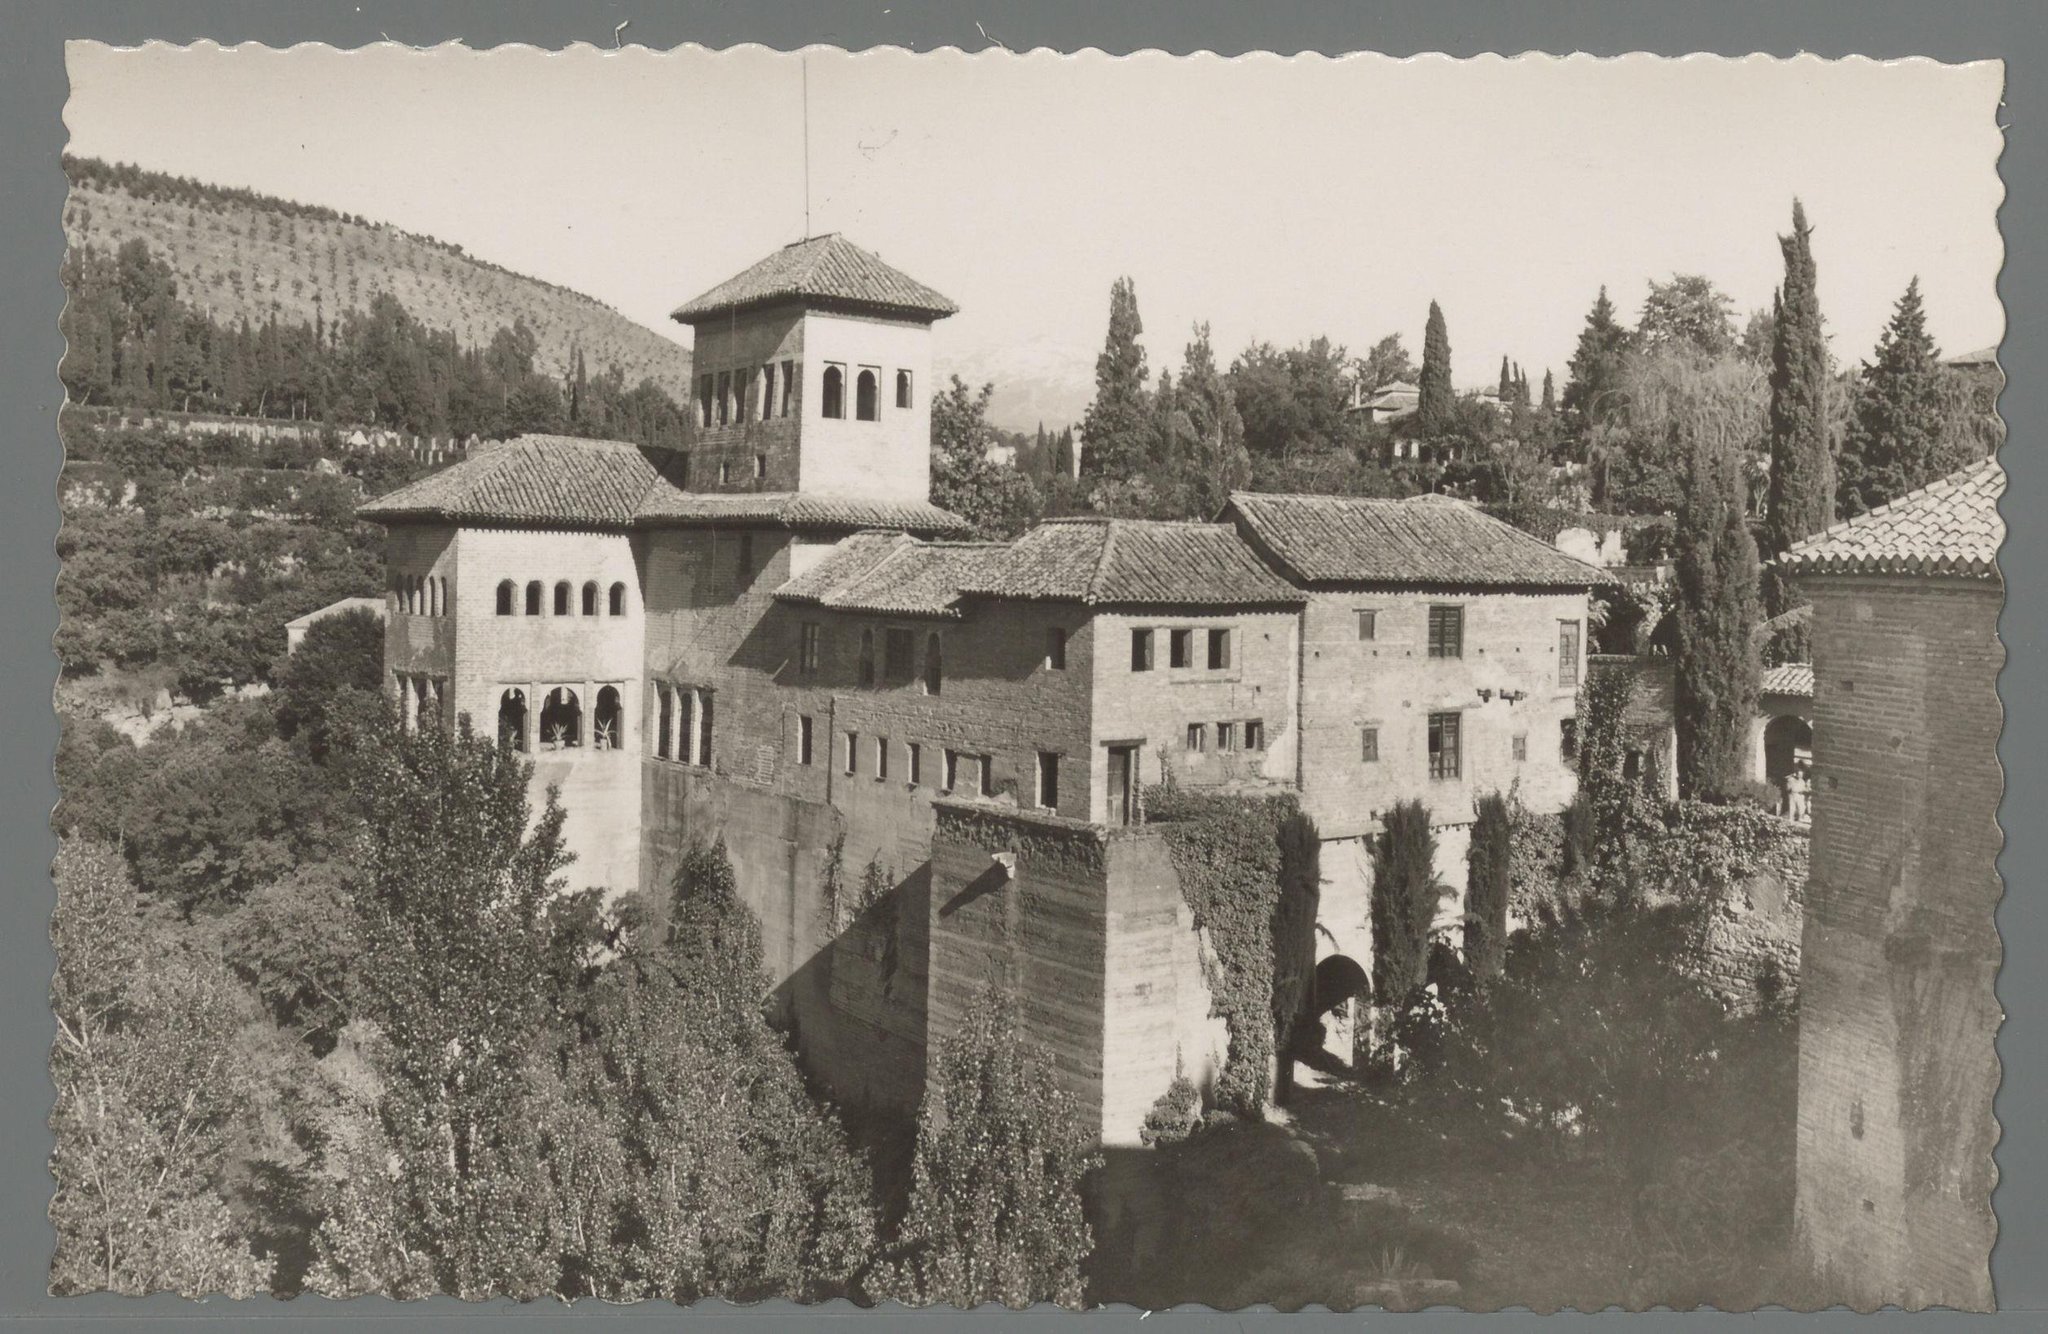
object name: photograph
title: Granada: La Alhambra. Torre de las Damas / The Alhambra. The Ladies' tower / L'Alhambra. Tour des Dames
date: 1906-1930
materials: paper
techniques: gelatin silver print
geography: zaragoza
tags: palace